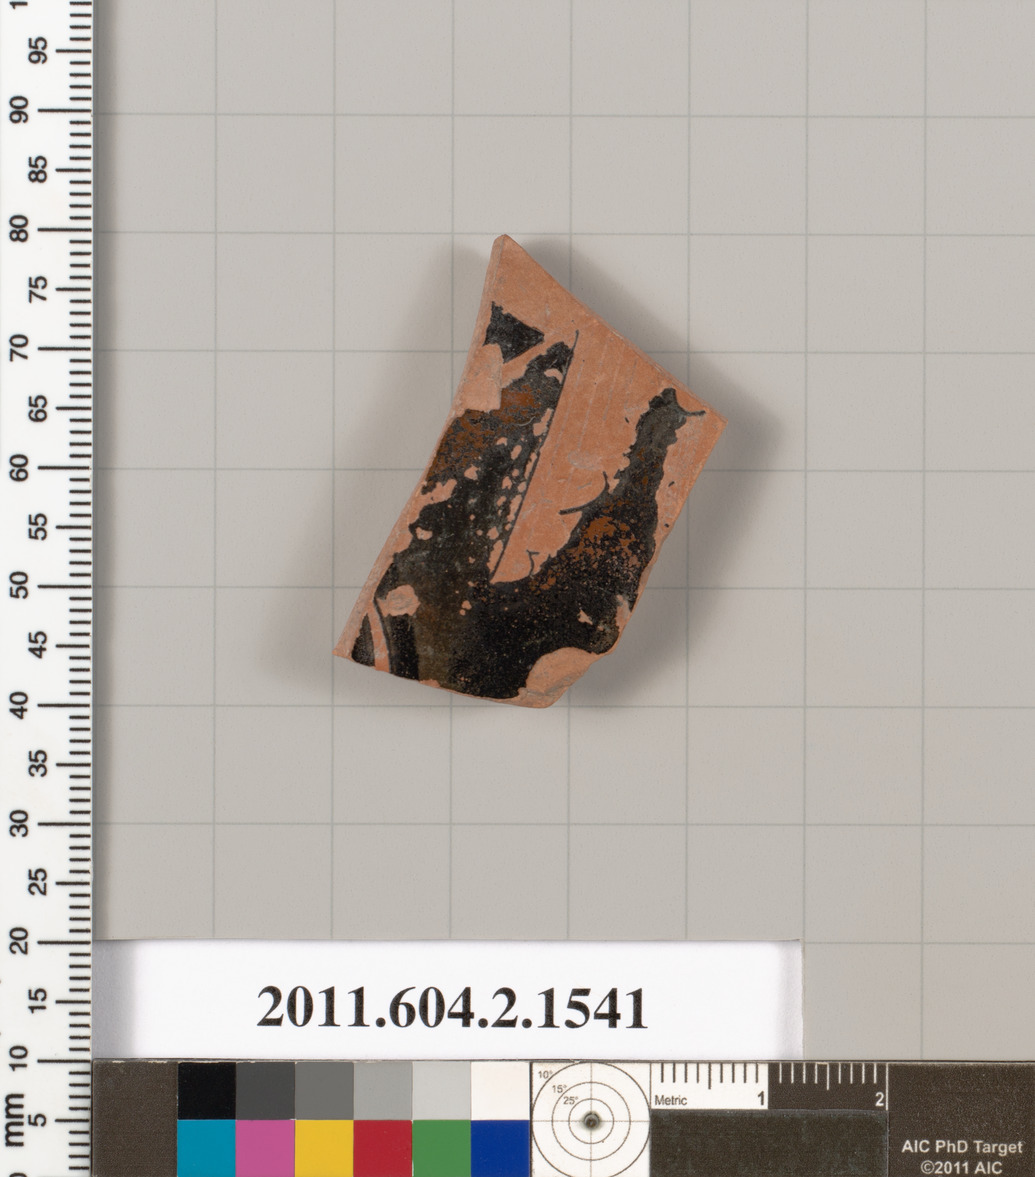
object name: skyphos fragment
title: Terracotta fragment of a skyphos (deep drinking cup)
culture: greek, attic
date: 475-451 BCE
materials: terracotta